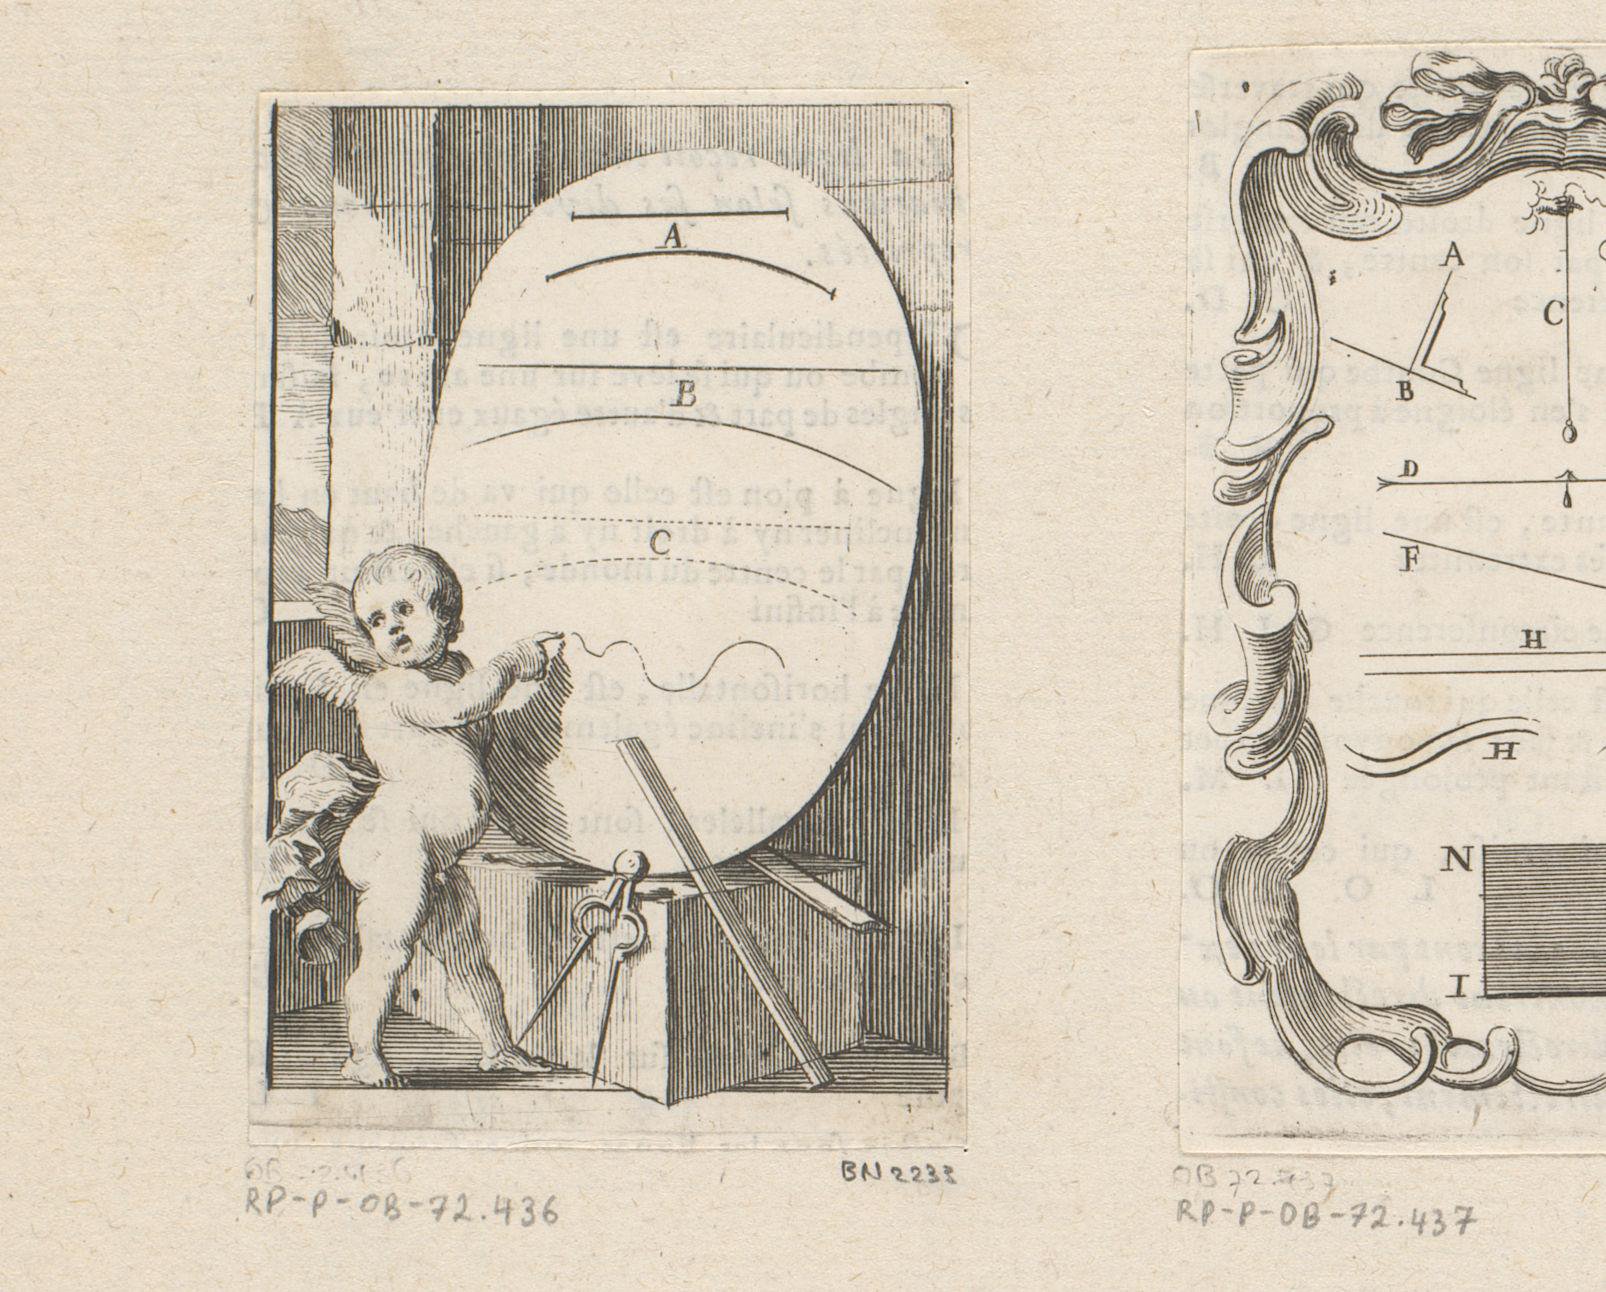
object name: book illustration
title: Eindige en oneindige lijnen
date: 1669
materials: paper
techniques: etching, letterpress printing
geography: france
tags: line (~ planimetry, geometry), cupids: 'amores', 'amoretti', 'putti'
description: Prent uit: Pratique de la géometrie, sur le papier et sur le terrain. Avec un nouvel ordre et une méthode particulière. Parijs: Thomas Jolly, 1669.